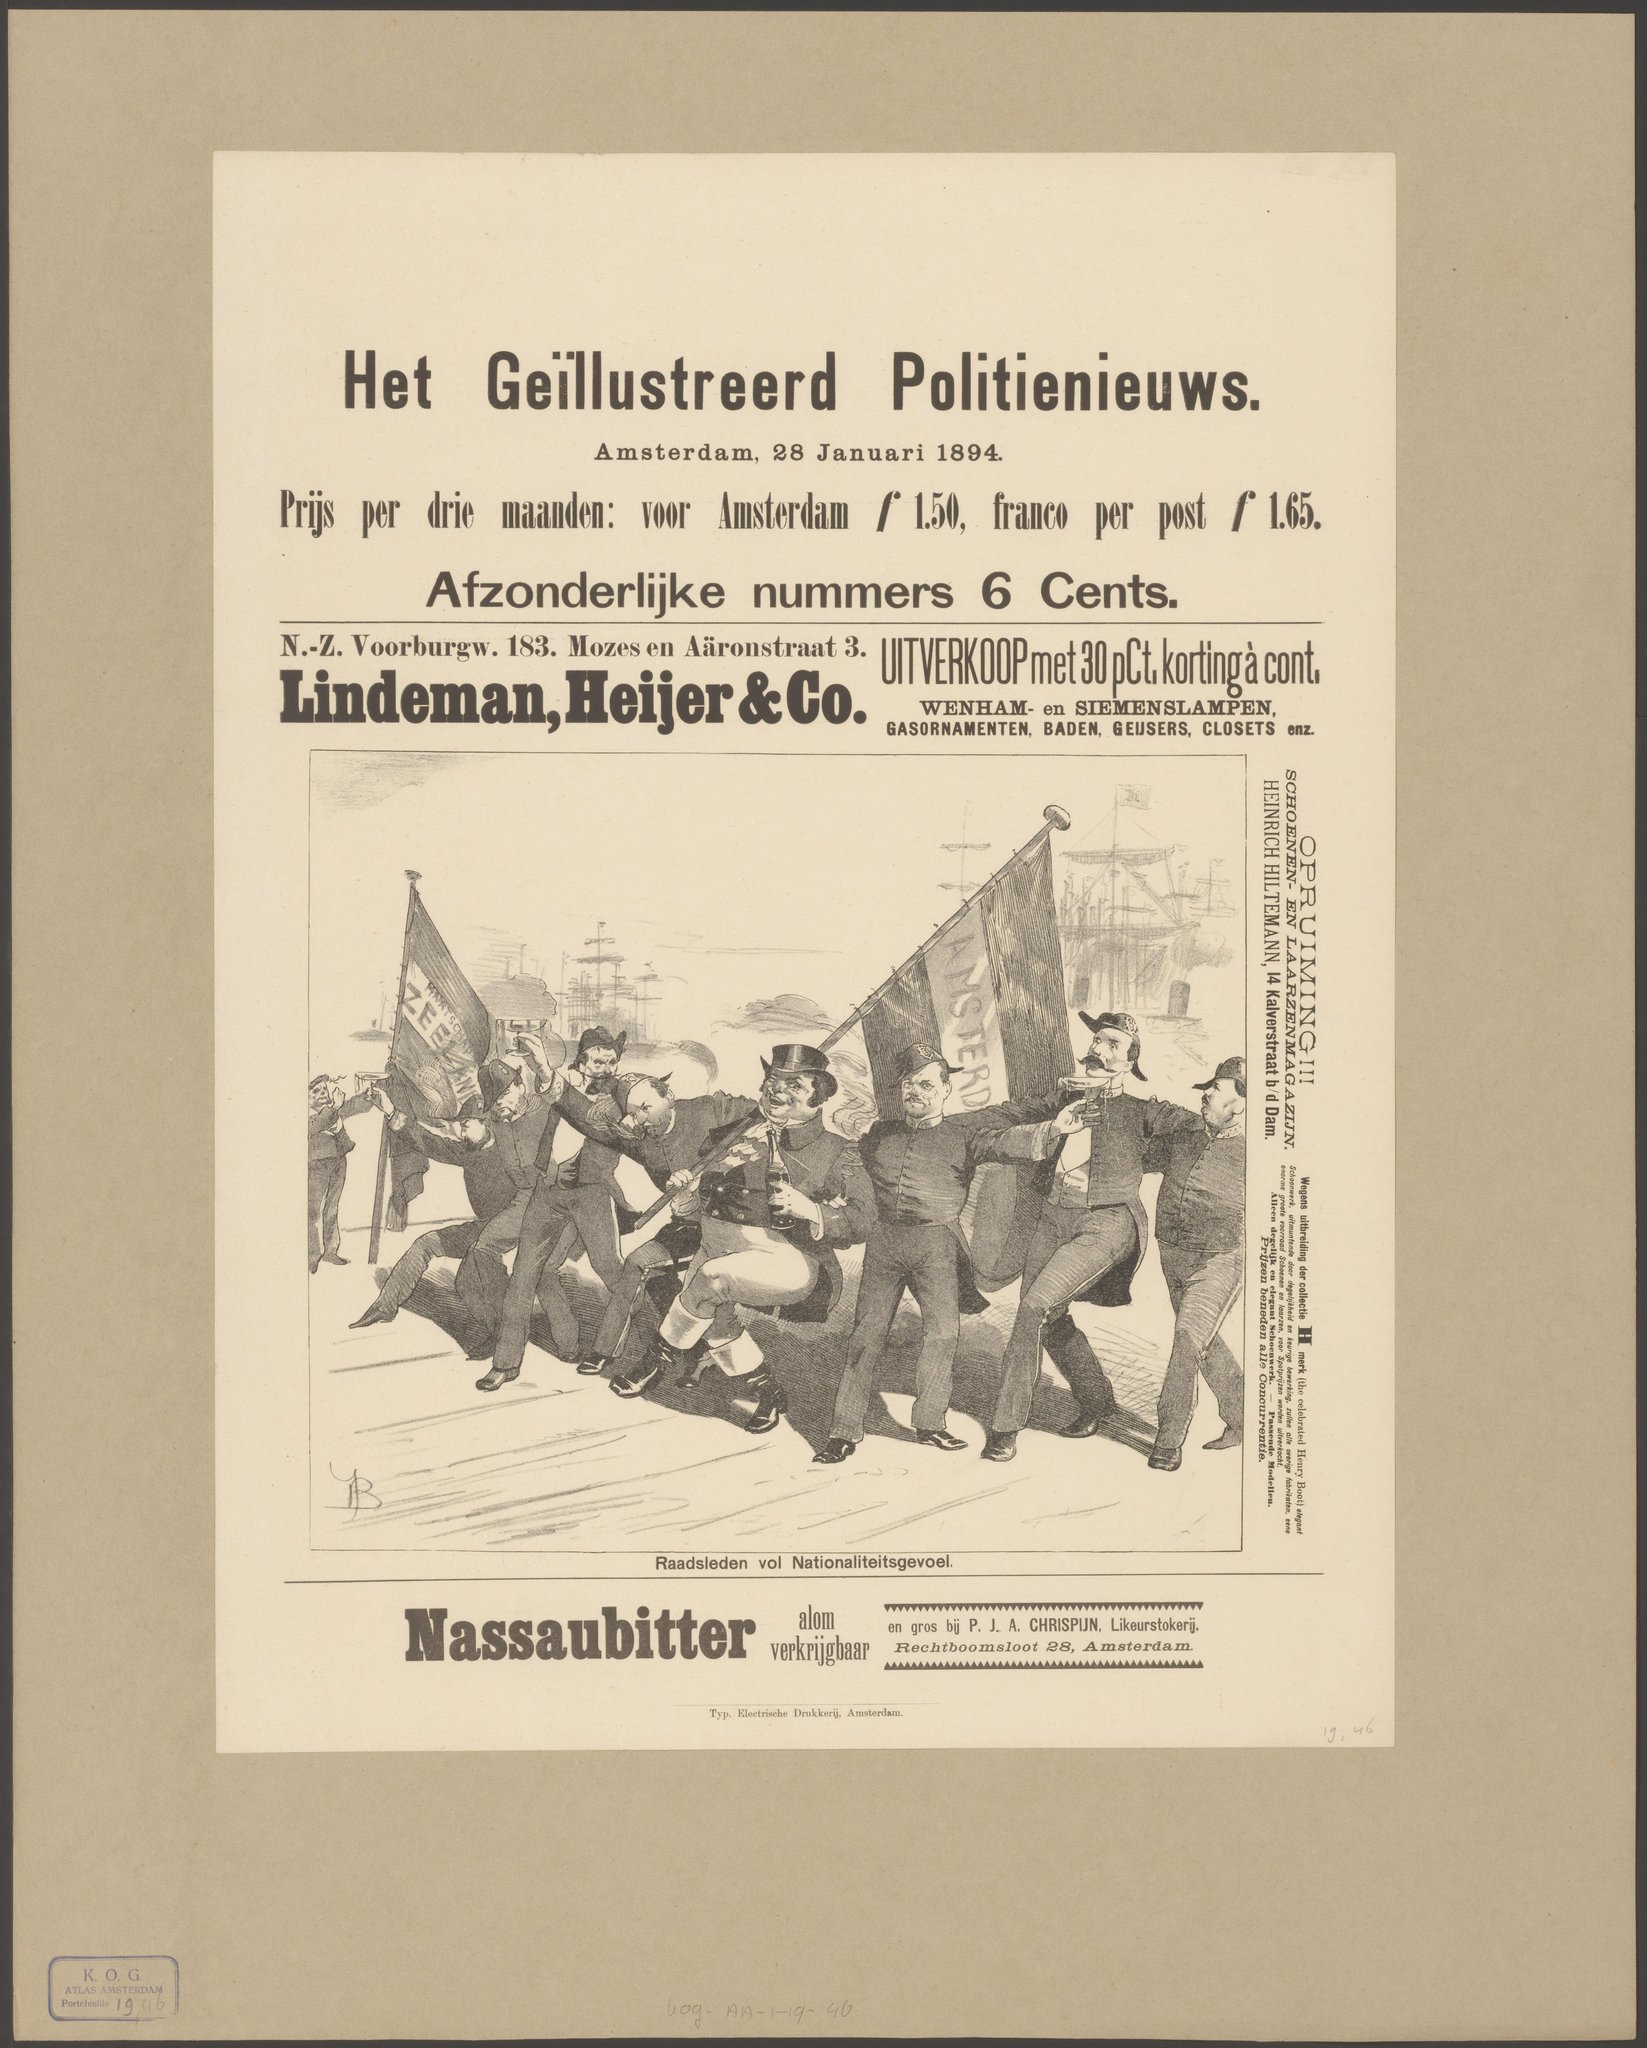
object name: cartoon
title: Raadsleden vol Nationaliteitsgevoel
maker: johan braakensiek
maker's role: draughtsman, print maker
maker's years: 1858-1940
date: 1894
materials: paper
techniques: letterpress printing, lithograph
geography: amsterdam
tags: political caricatures and satires, amsterdam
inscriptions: collector's mark: ‘19,46’ Lugt 1641b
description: Onderwerpsrubriek binnen de Atlas Amsterdam: Herinneringen aan regeringsleden en hunne huisgezinnen [na 1800].